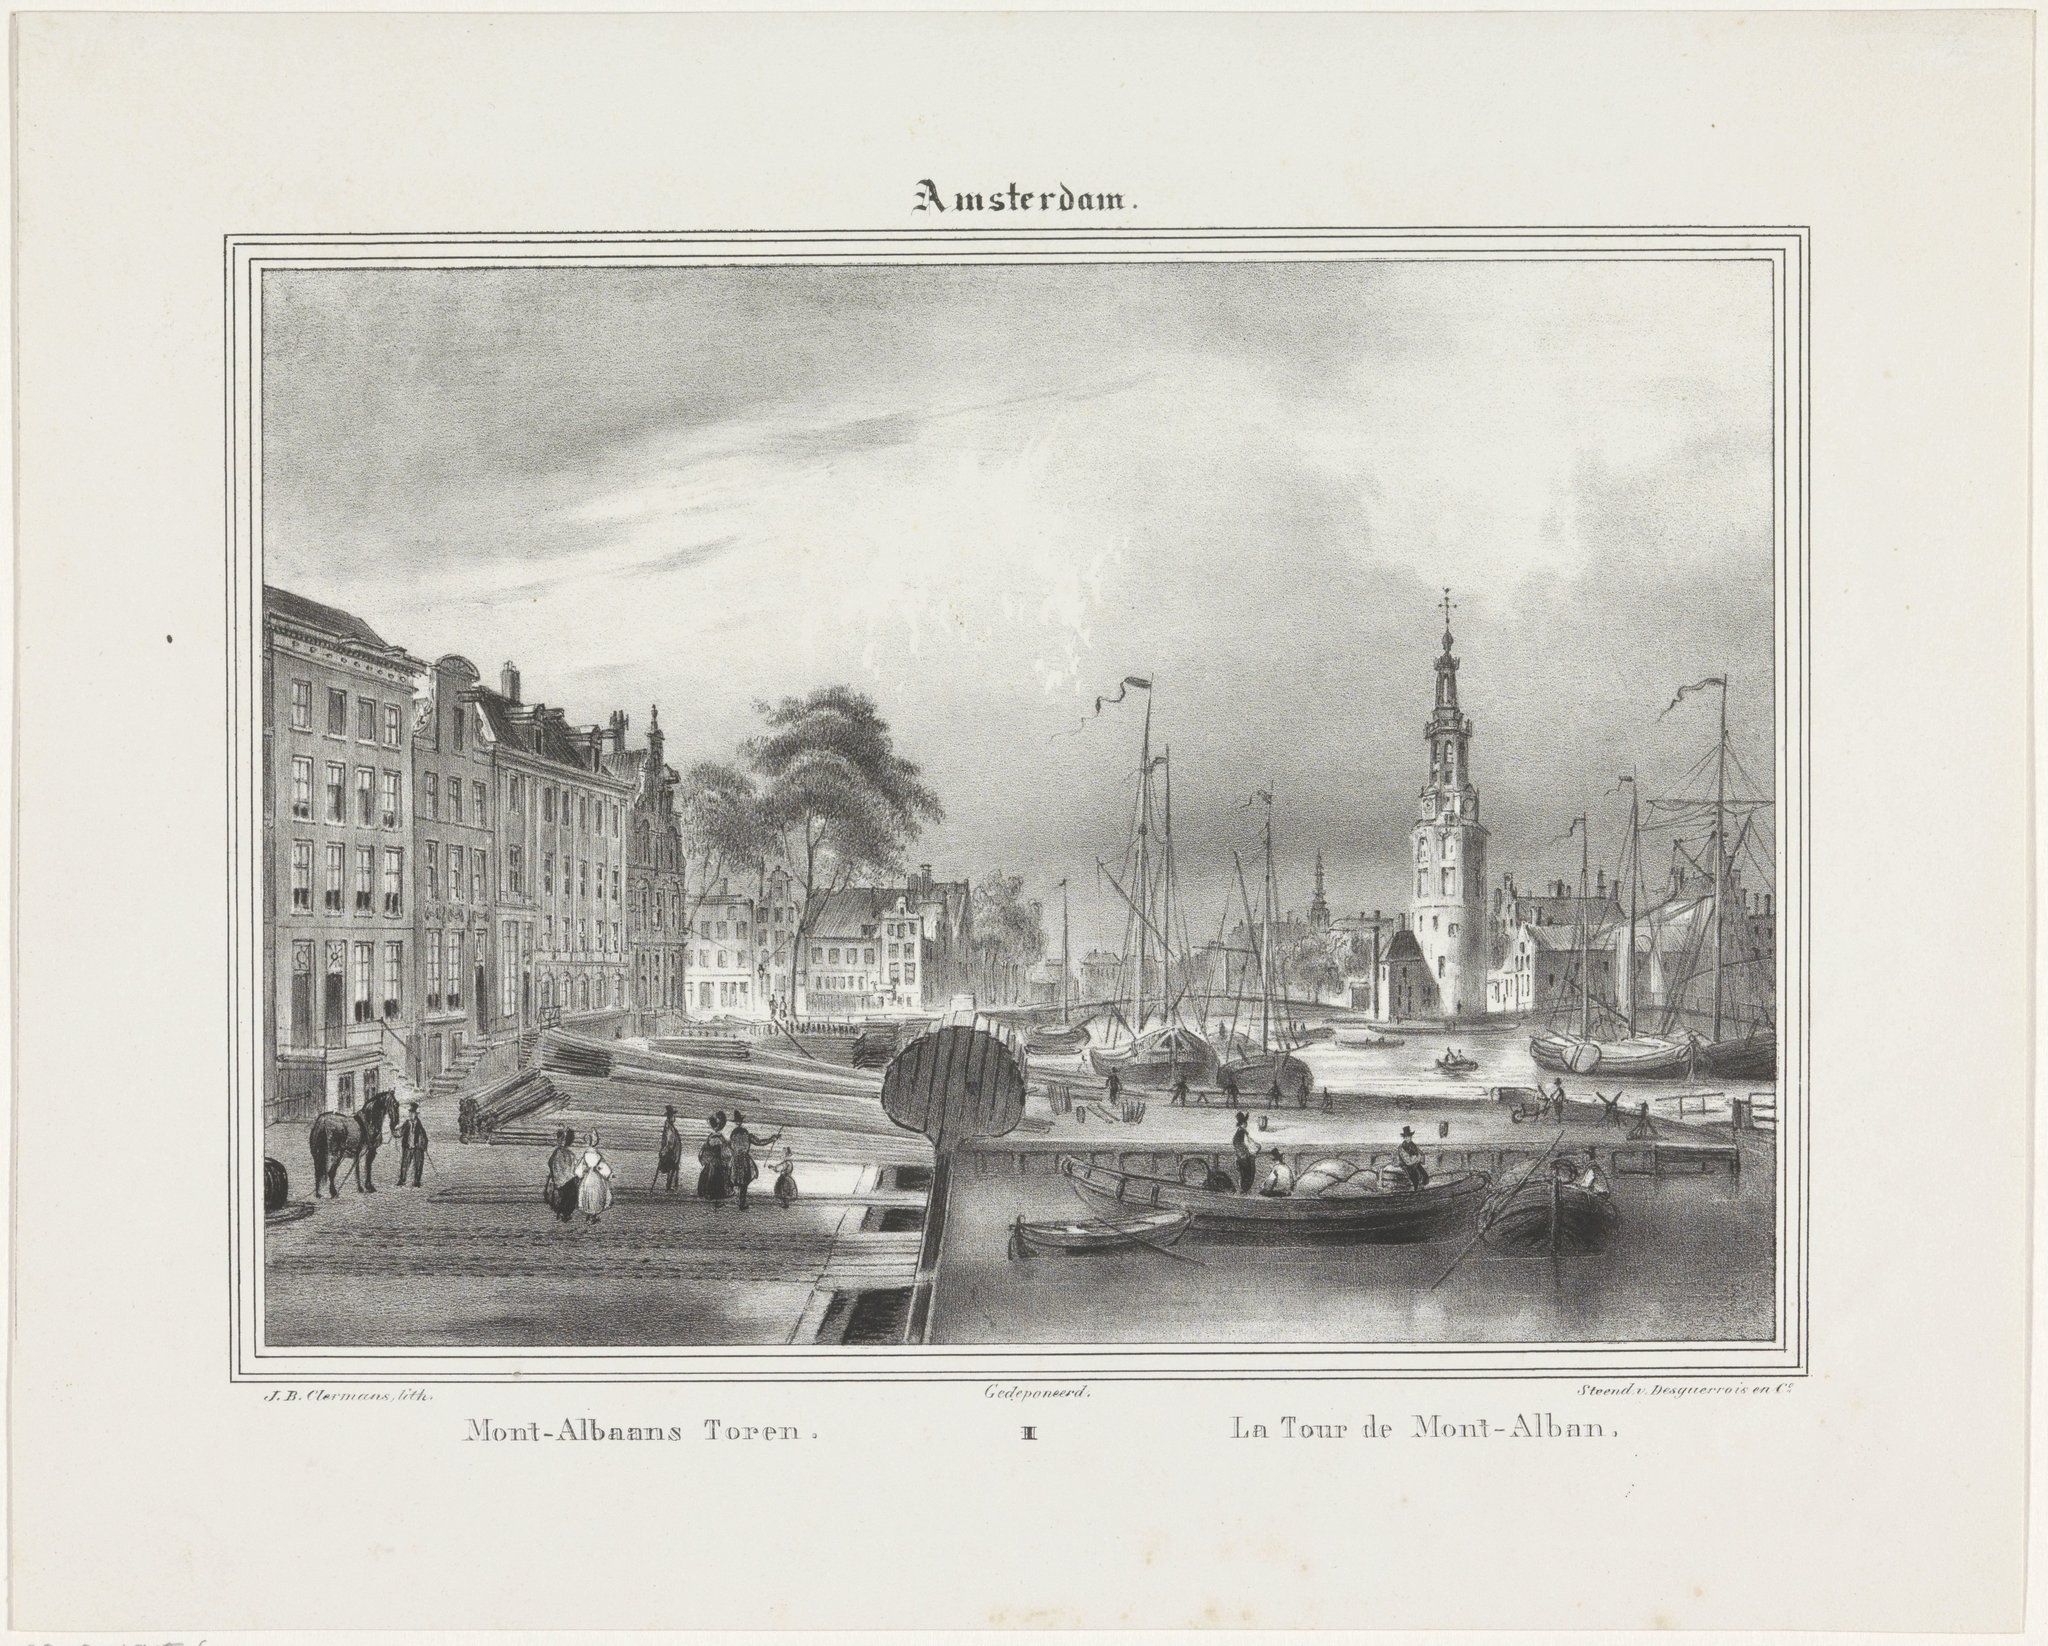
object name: print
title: Gezicht op de Oudeschans en Montelbaanstoren te Amsterdam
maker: j.b. clermans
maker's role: print maker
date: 1826-1839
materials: paper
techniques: lithograph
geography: amsterdam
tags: tower, clock tower ~ monumental adornment, canals, waters (in city), pier, quay, wharf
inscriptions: collector's mark: Lugt 2228, : ‘Gedeponeerd.’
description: Links wordt hout verzameld op het 's-Gravenhekje. Aan de kant van de gracht en op de pier lopen figuren. In het water liggen verschillende roeiboten en zeilschepen.